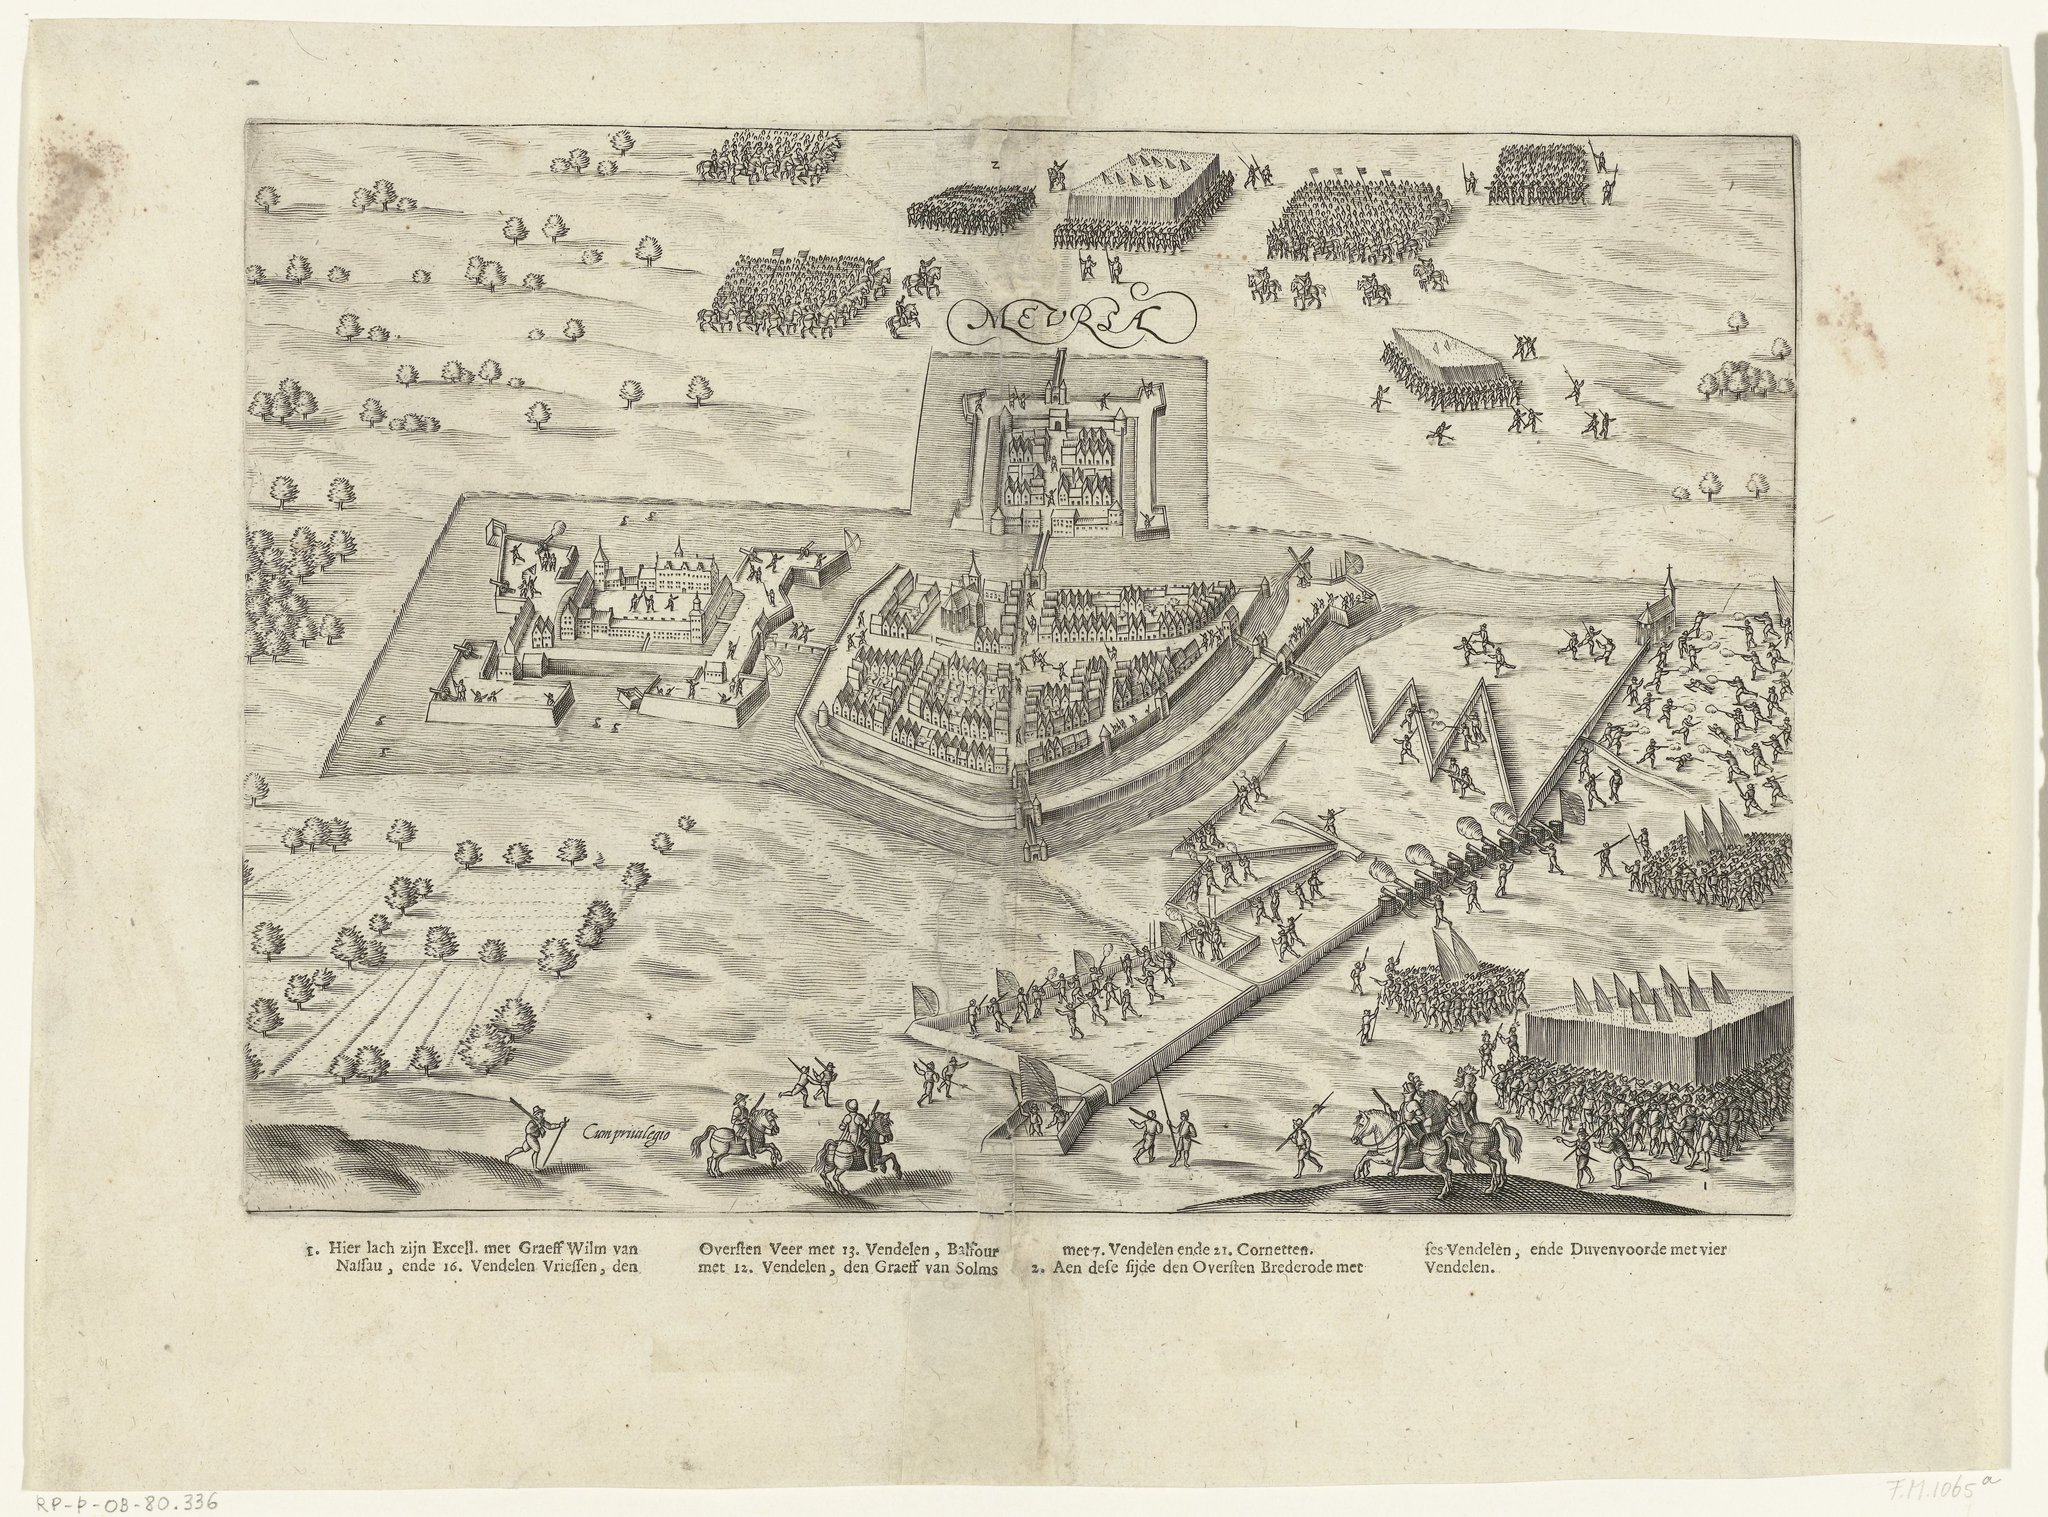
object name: print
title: Beleg en verovering van Meurs, 1597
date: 1600-1601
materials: paper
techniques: engraving, letterpress printing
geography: northern netherlands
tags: maurice (prince of orange), siege, position war, capture of city (after the siege)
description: Gebruikt als illustratie in: J.J. Orlers, Den Nassauschen Lauren-Crans: Beschrijvinghe ende af-beeldinge van alle de victorien ... die Godt Almachtich de ... Staten der Vereenichde Nederlanden verleent heeft, deur het wijs ende clouck beleyt des Hooch-ghebooren Fursts Maurits van Nassau, J.J. Orlers en H. van Haestens, Leiden 1610, fol. 120/121.